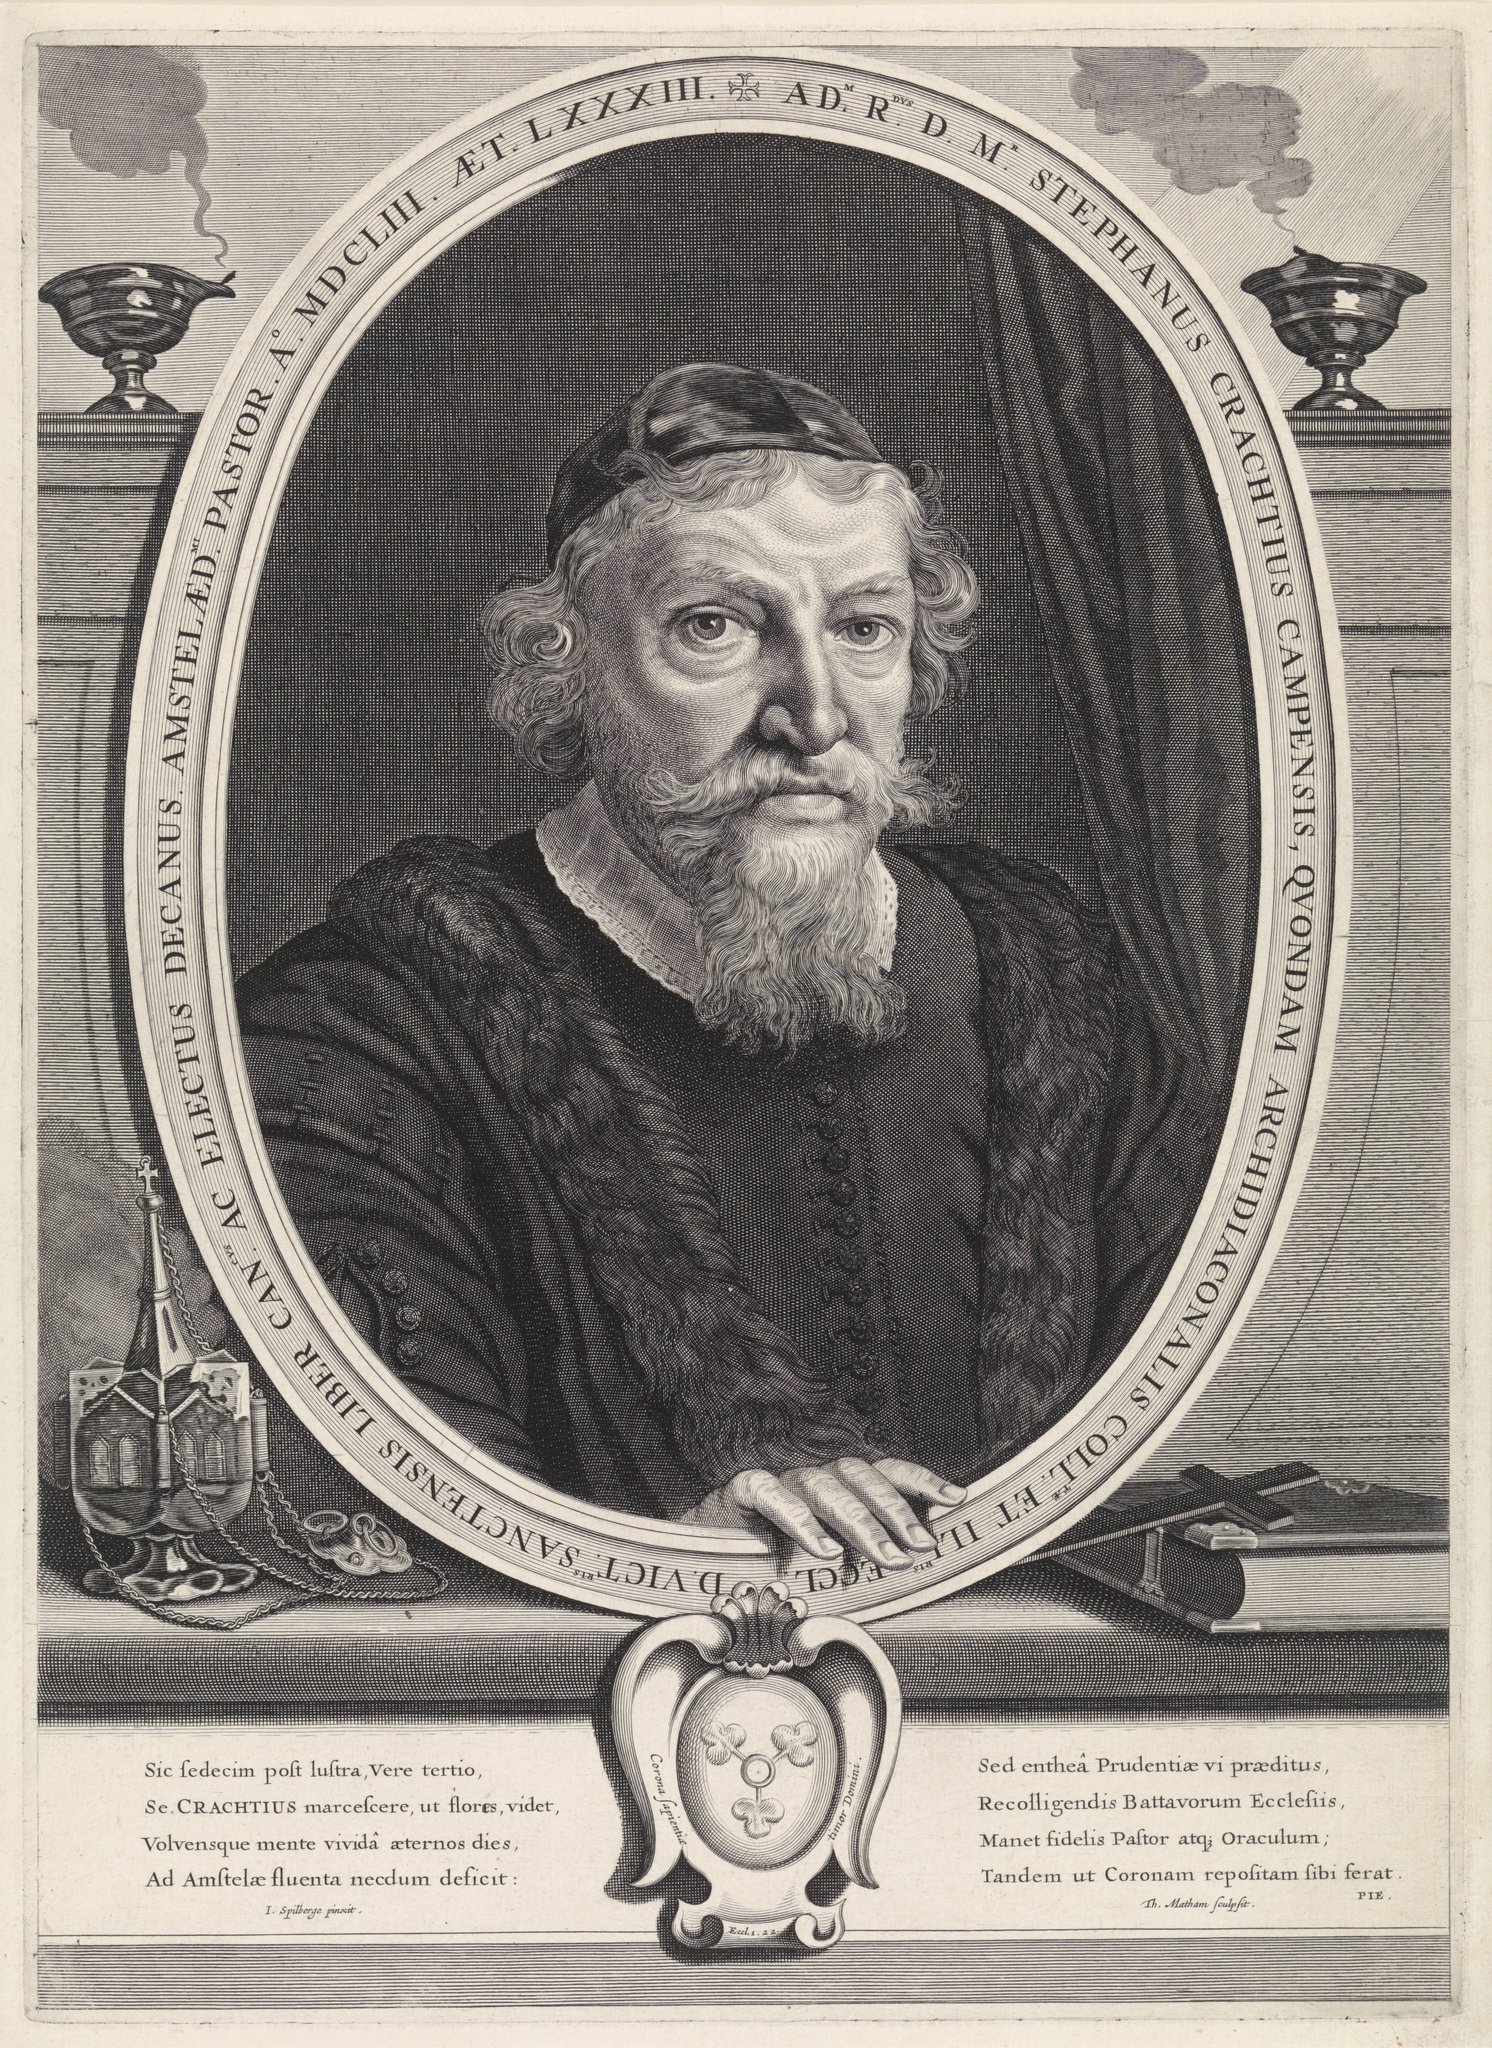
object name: print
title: Portret van Stephan Crachtius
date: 1653-1676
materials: paper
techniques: engraving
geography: northern netherlands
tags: incense used in the church, censer, smoking pot as symbol of 'vanitas'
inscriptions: collector's mark: Lugt 240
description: Portret van de Amsterdamse theoloog Stephan Crachtius in een ovaal. Naast het portret een bijbel en een wierooksvat en bovenaan twee rokende potten.